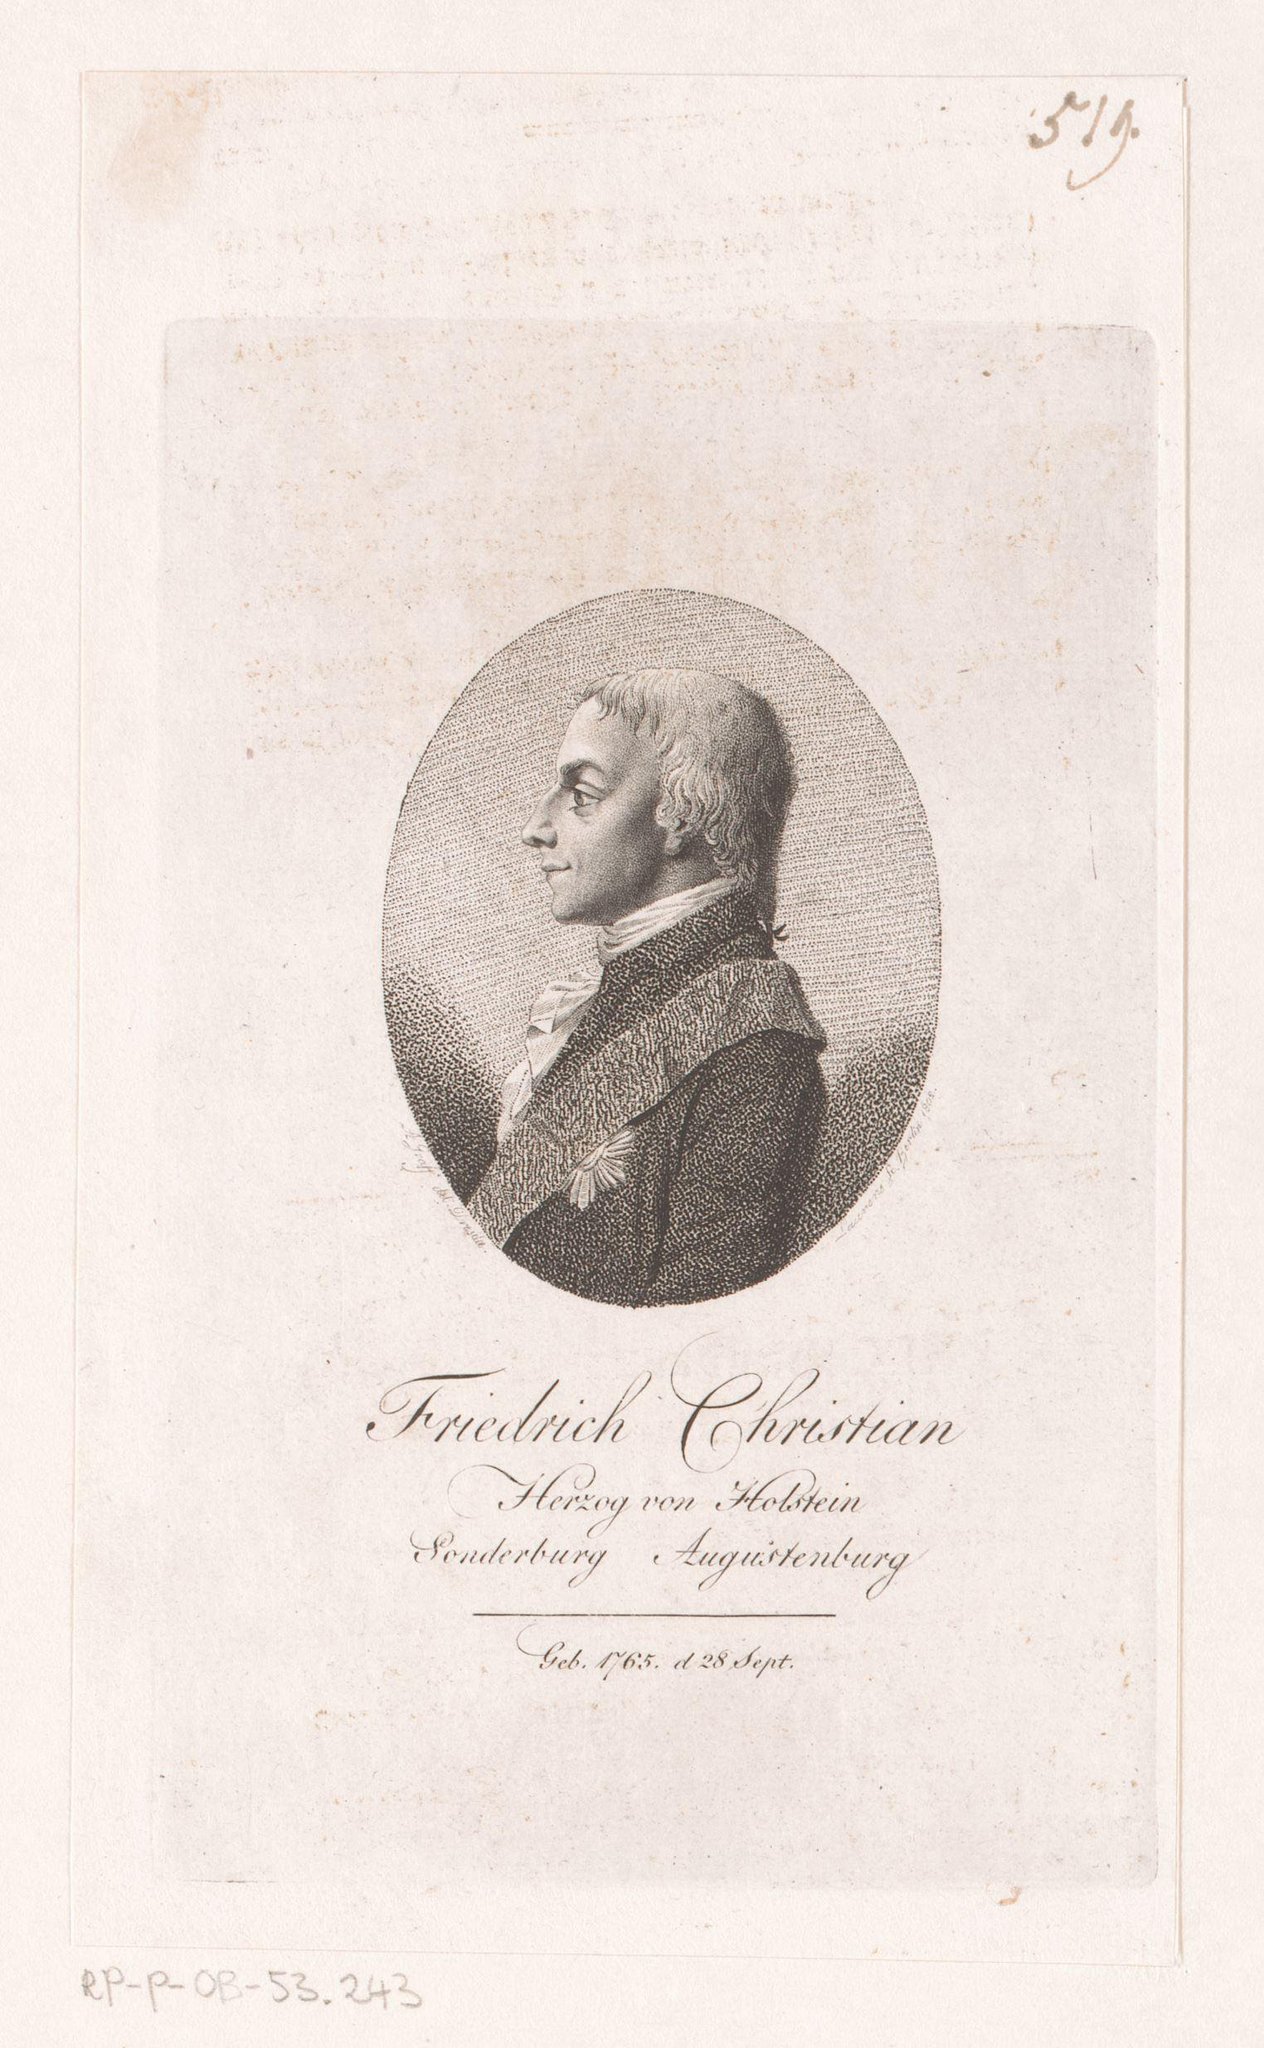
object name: print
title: Portret van Friedrich Christian hertog van Schleswig-Holstein-Sonderburg-Augustenburg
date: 1802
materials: paper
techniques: etching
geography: dresden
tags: historical persons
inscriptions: collector's mark: Lugt 2228